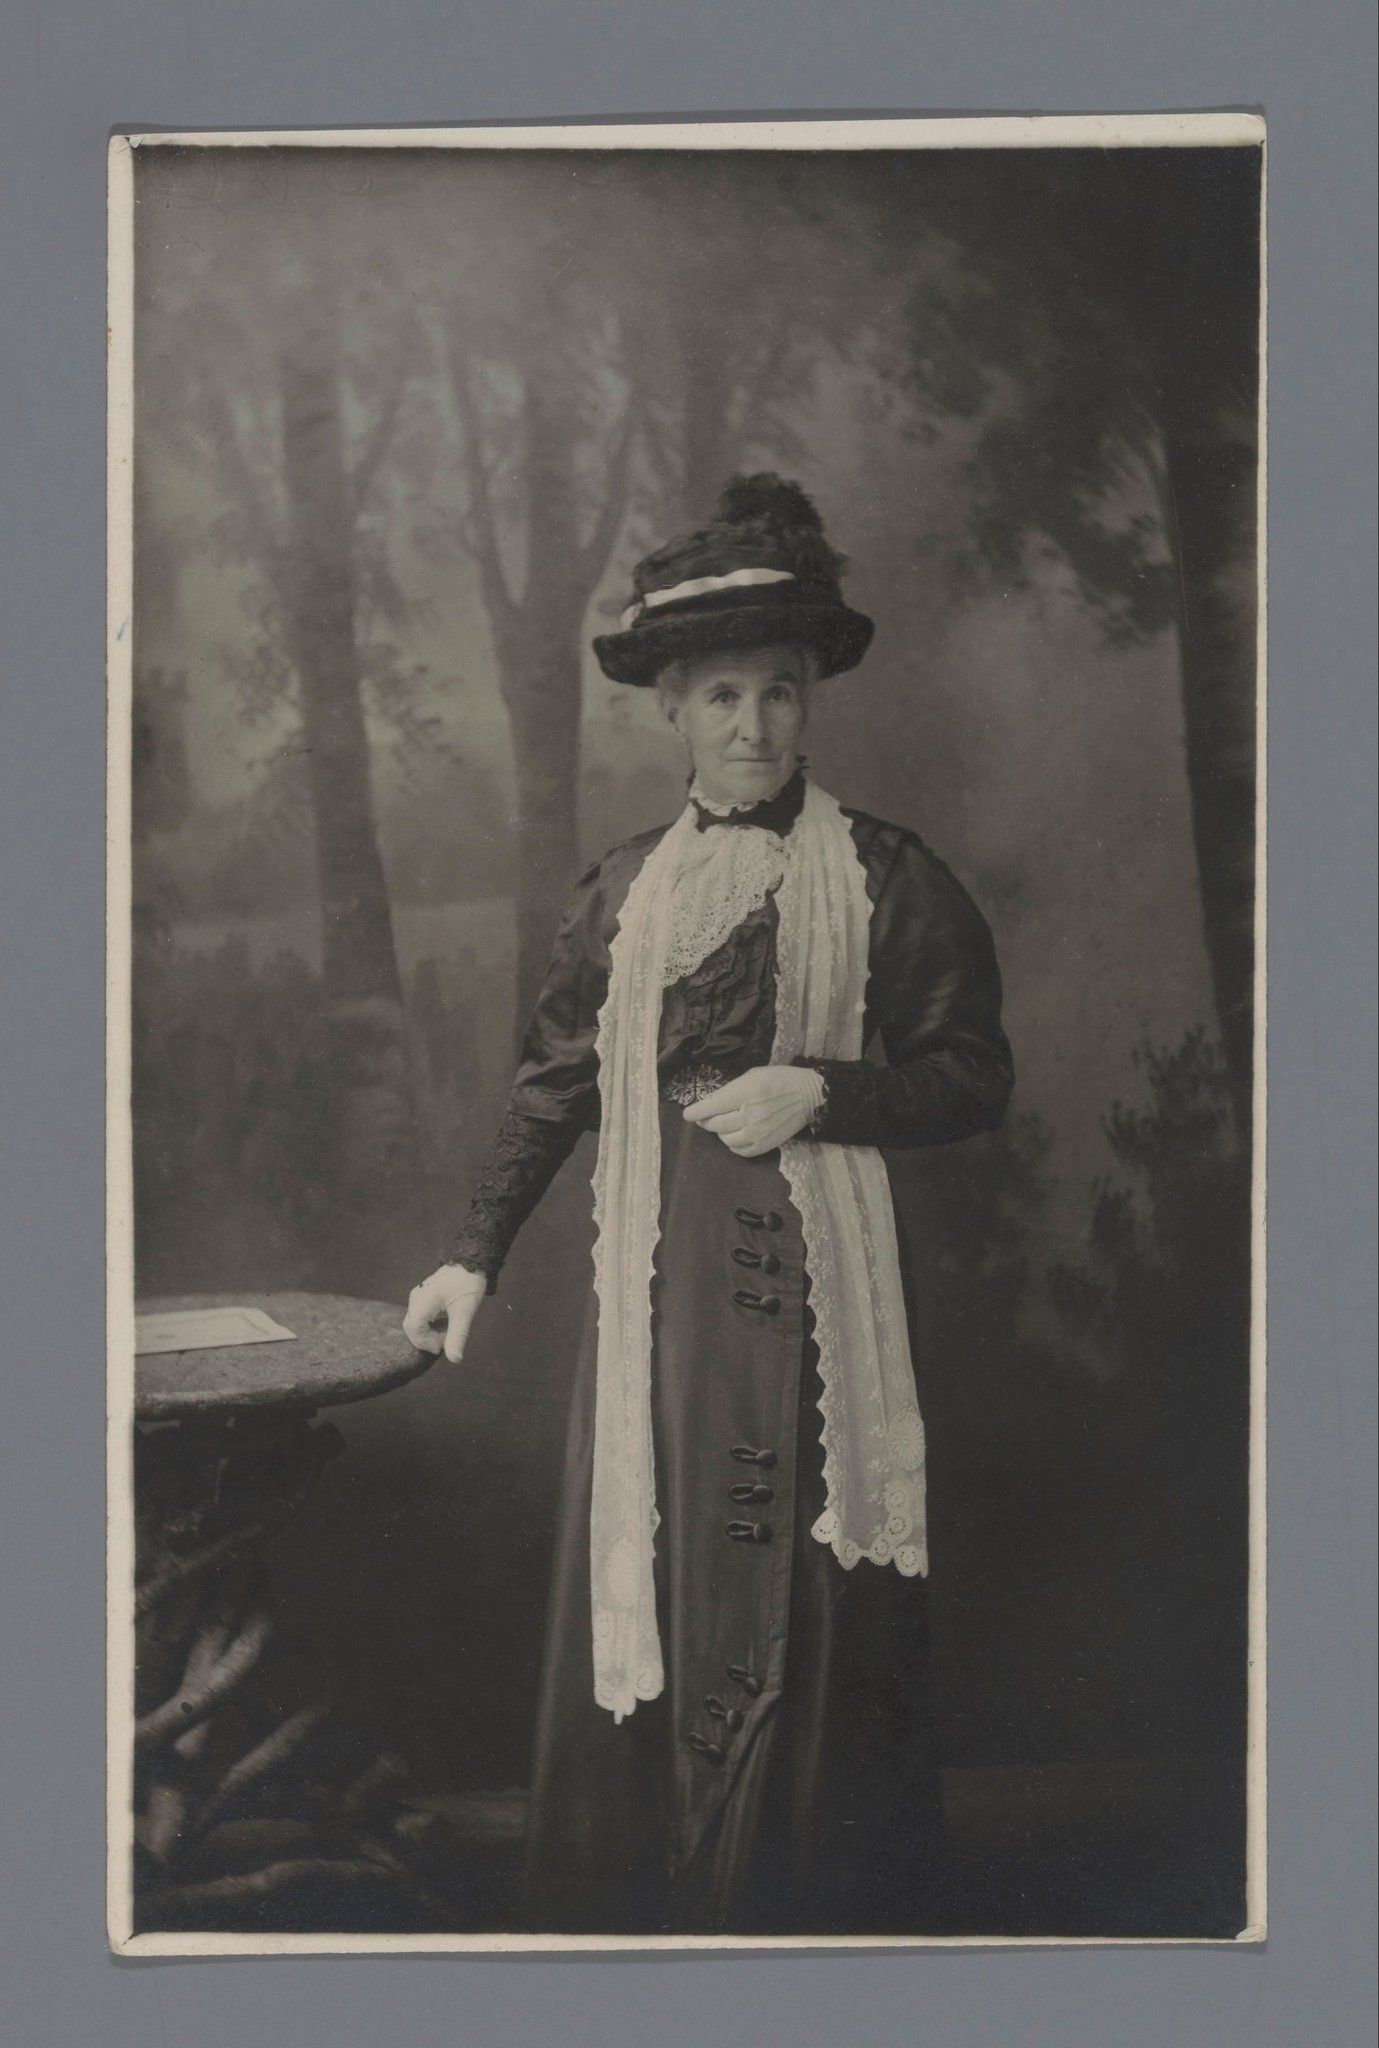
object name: photograph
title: Studioportret van een onbekende oude vrouw naast een stoel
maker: Anonymous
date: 1907-1920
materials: photographic support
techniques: gelatin silver print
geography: great britain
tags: studio ~ photographer, old woman, chair